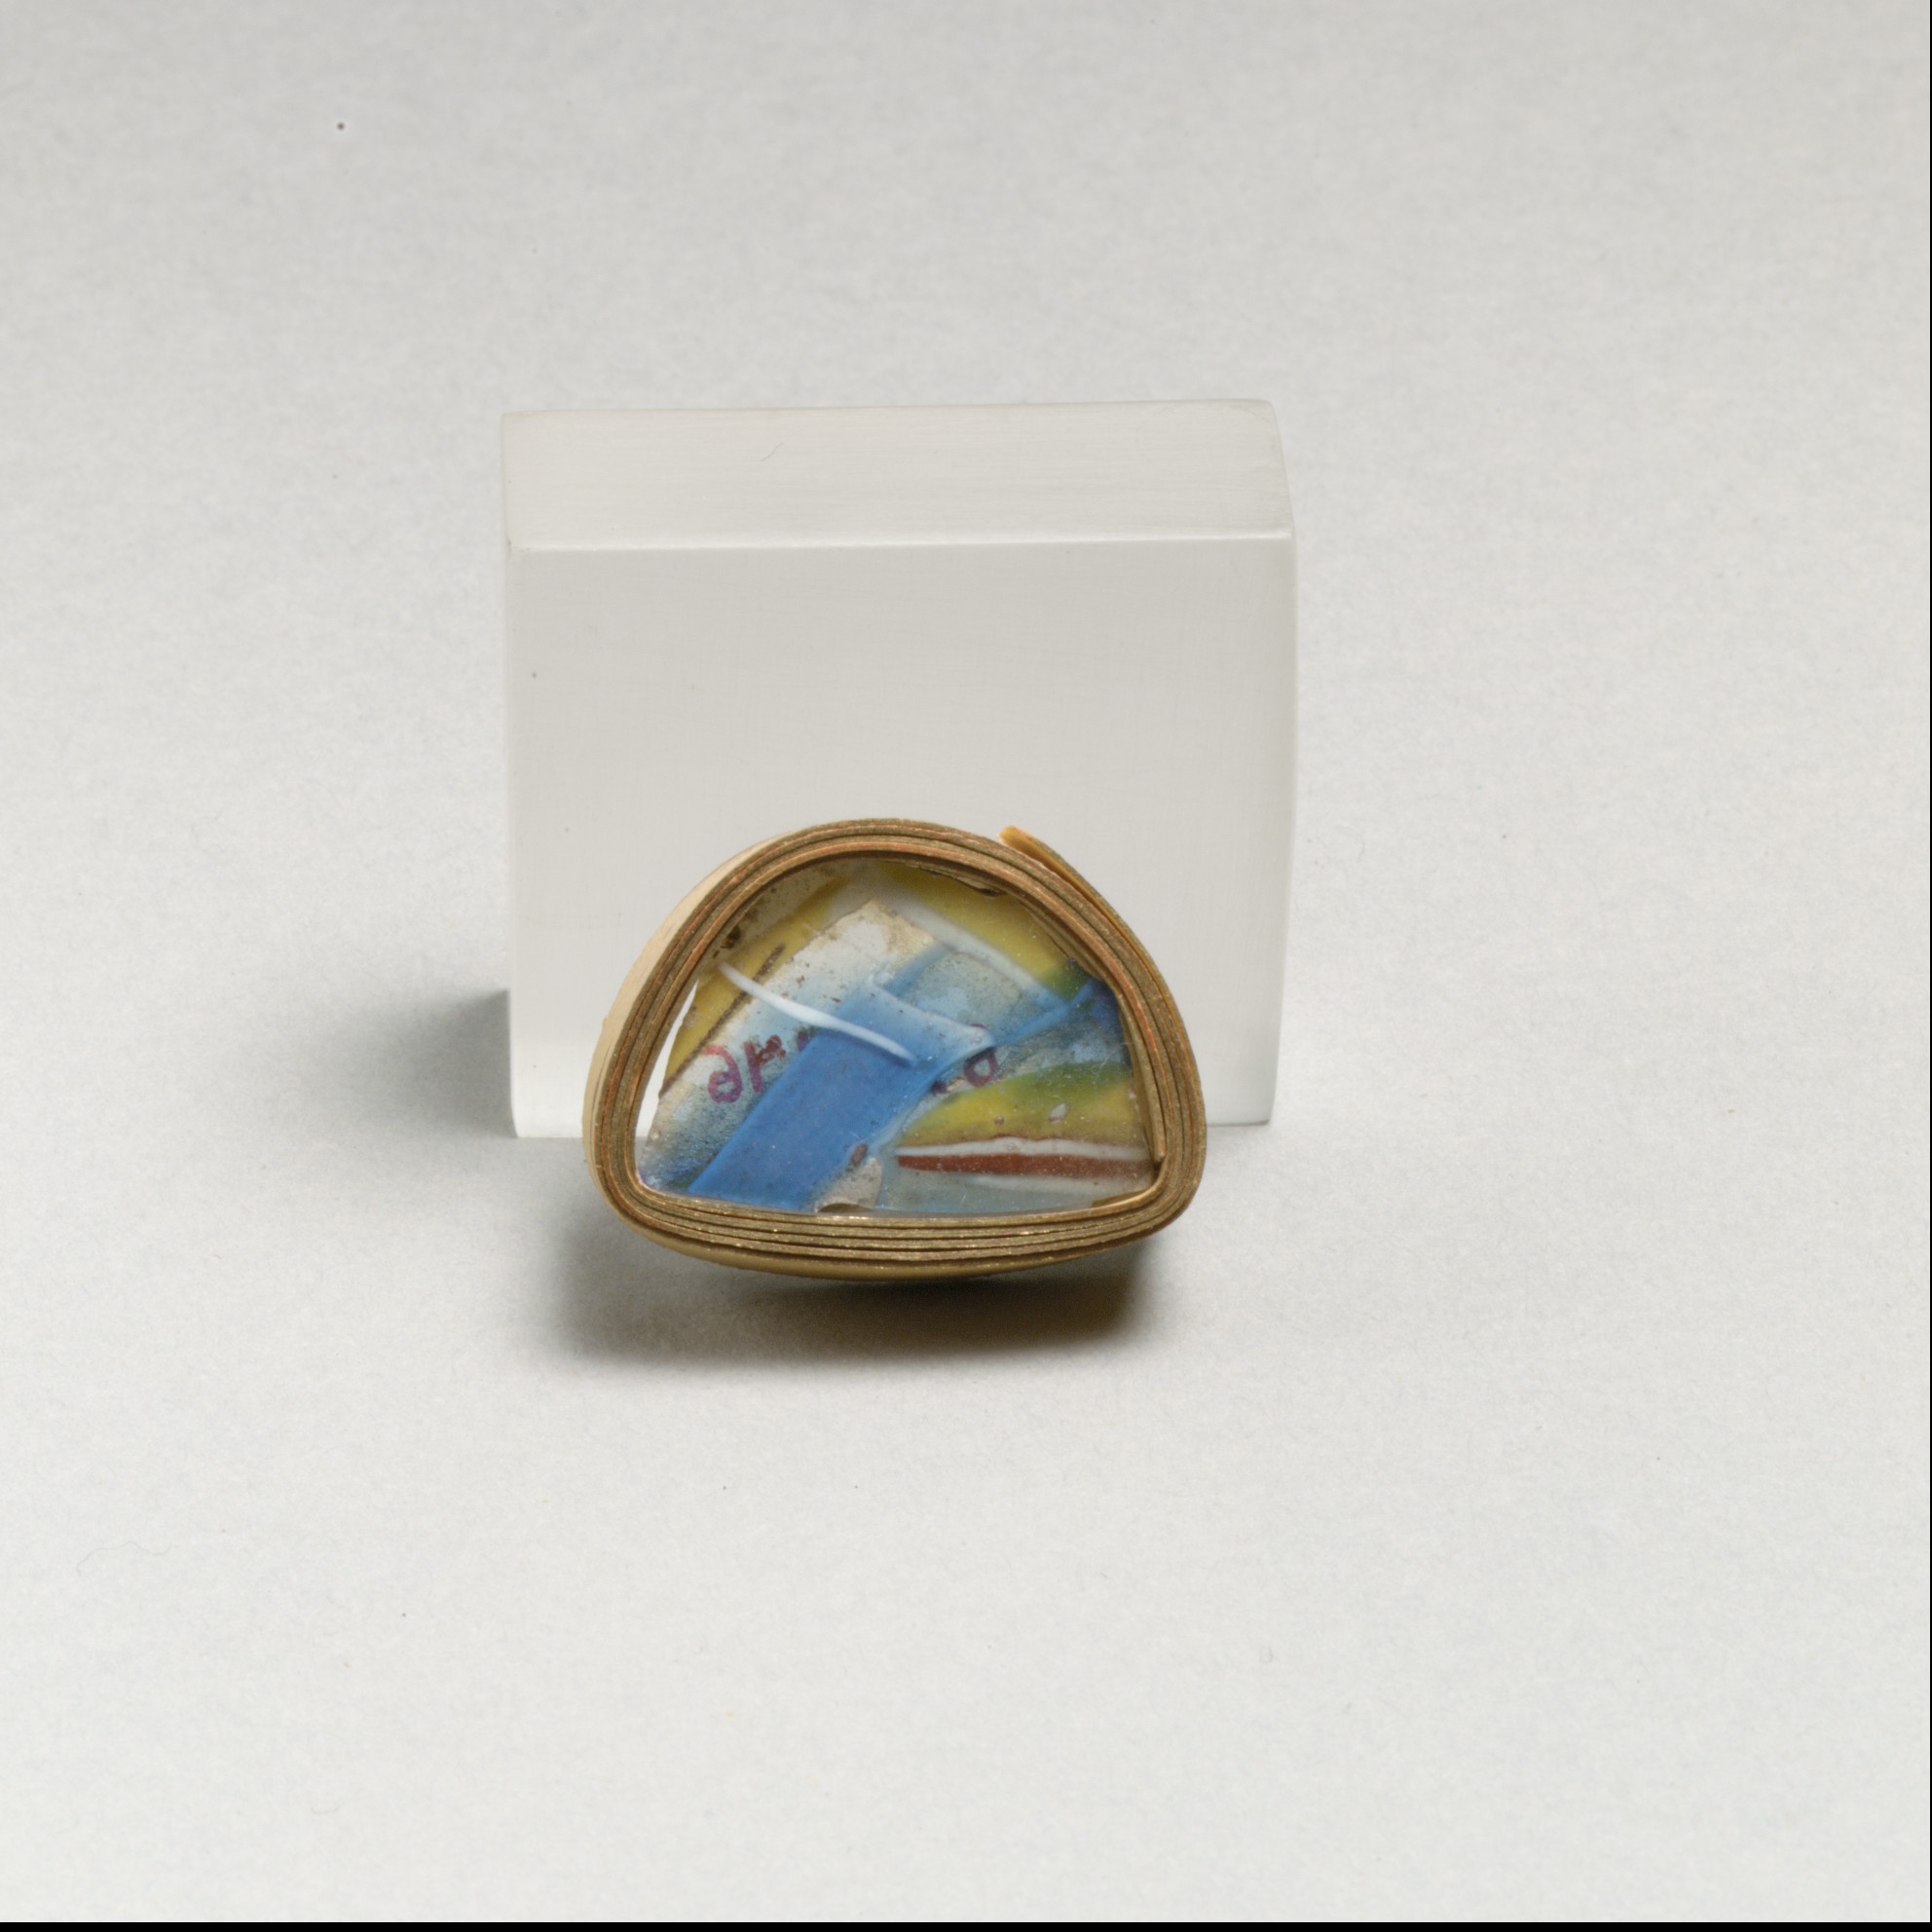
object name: fragment, short strip mosaic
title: Glass short-strip mosaic fragment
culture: roman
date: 34 BCE-33 CE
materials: glass